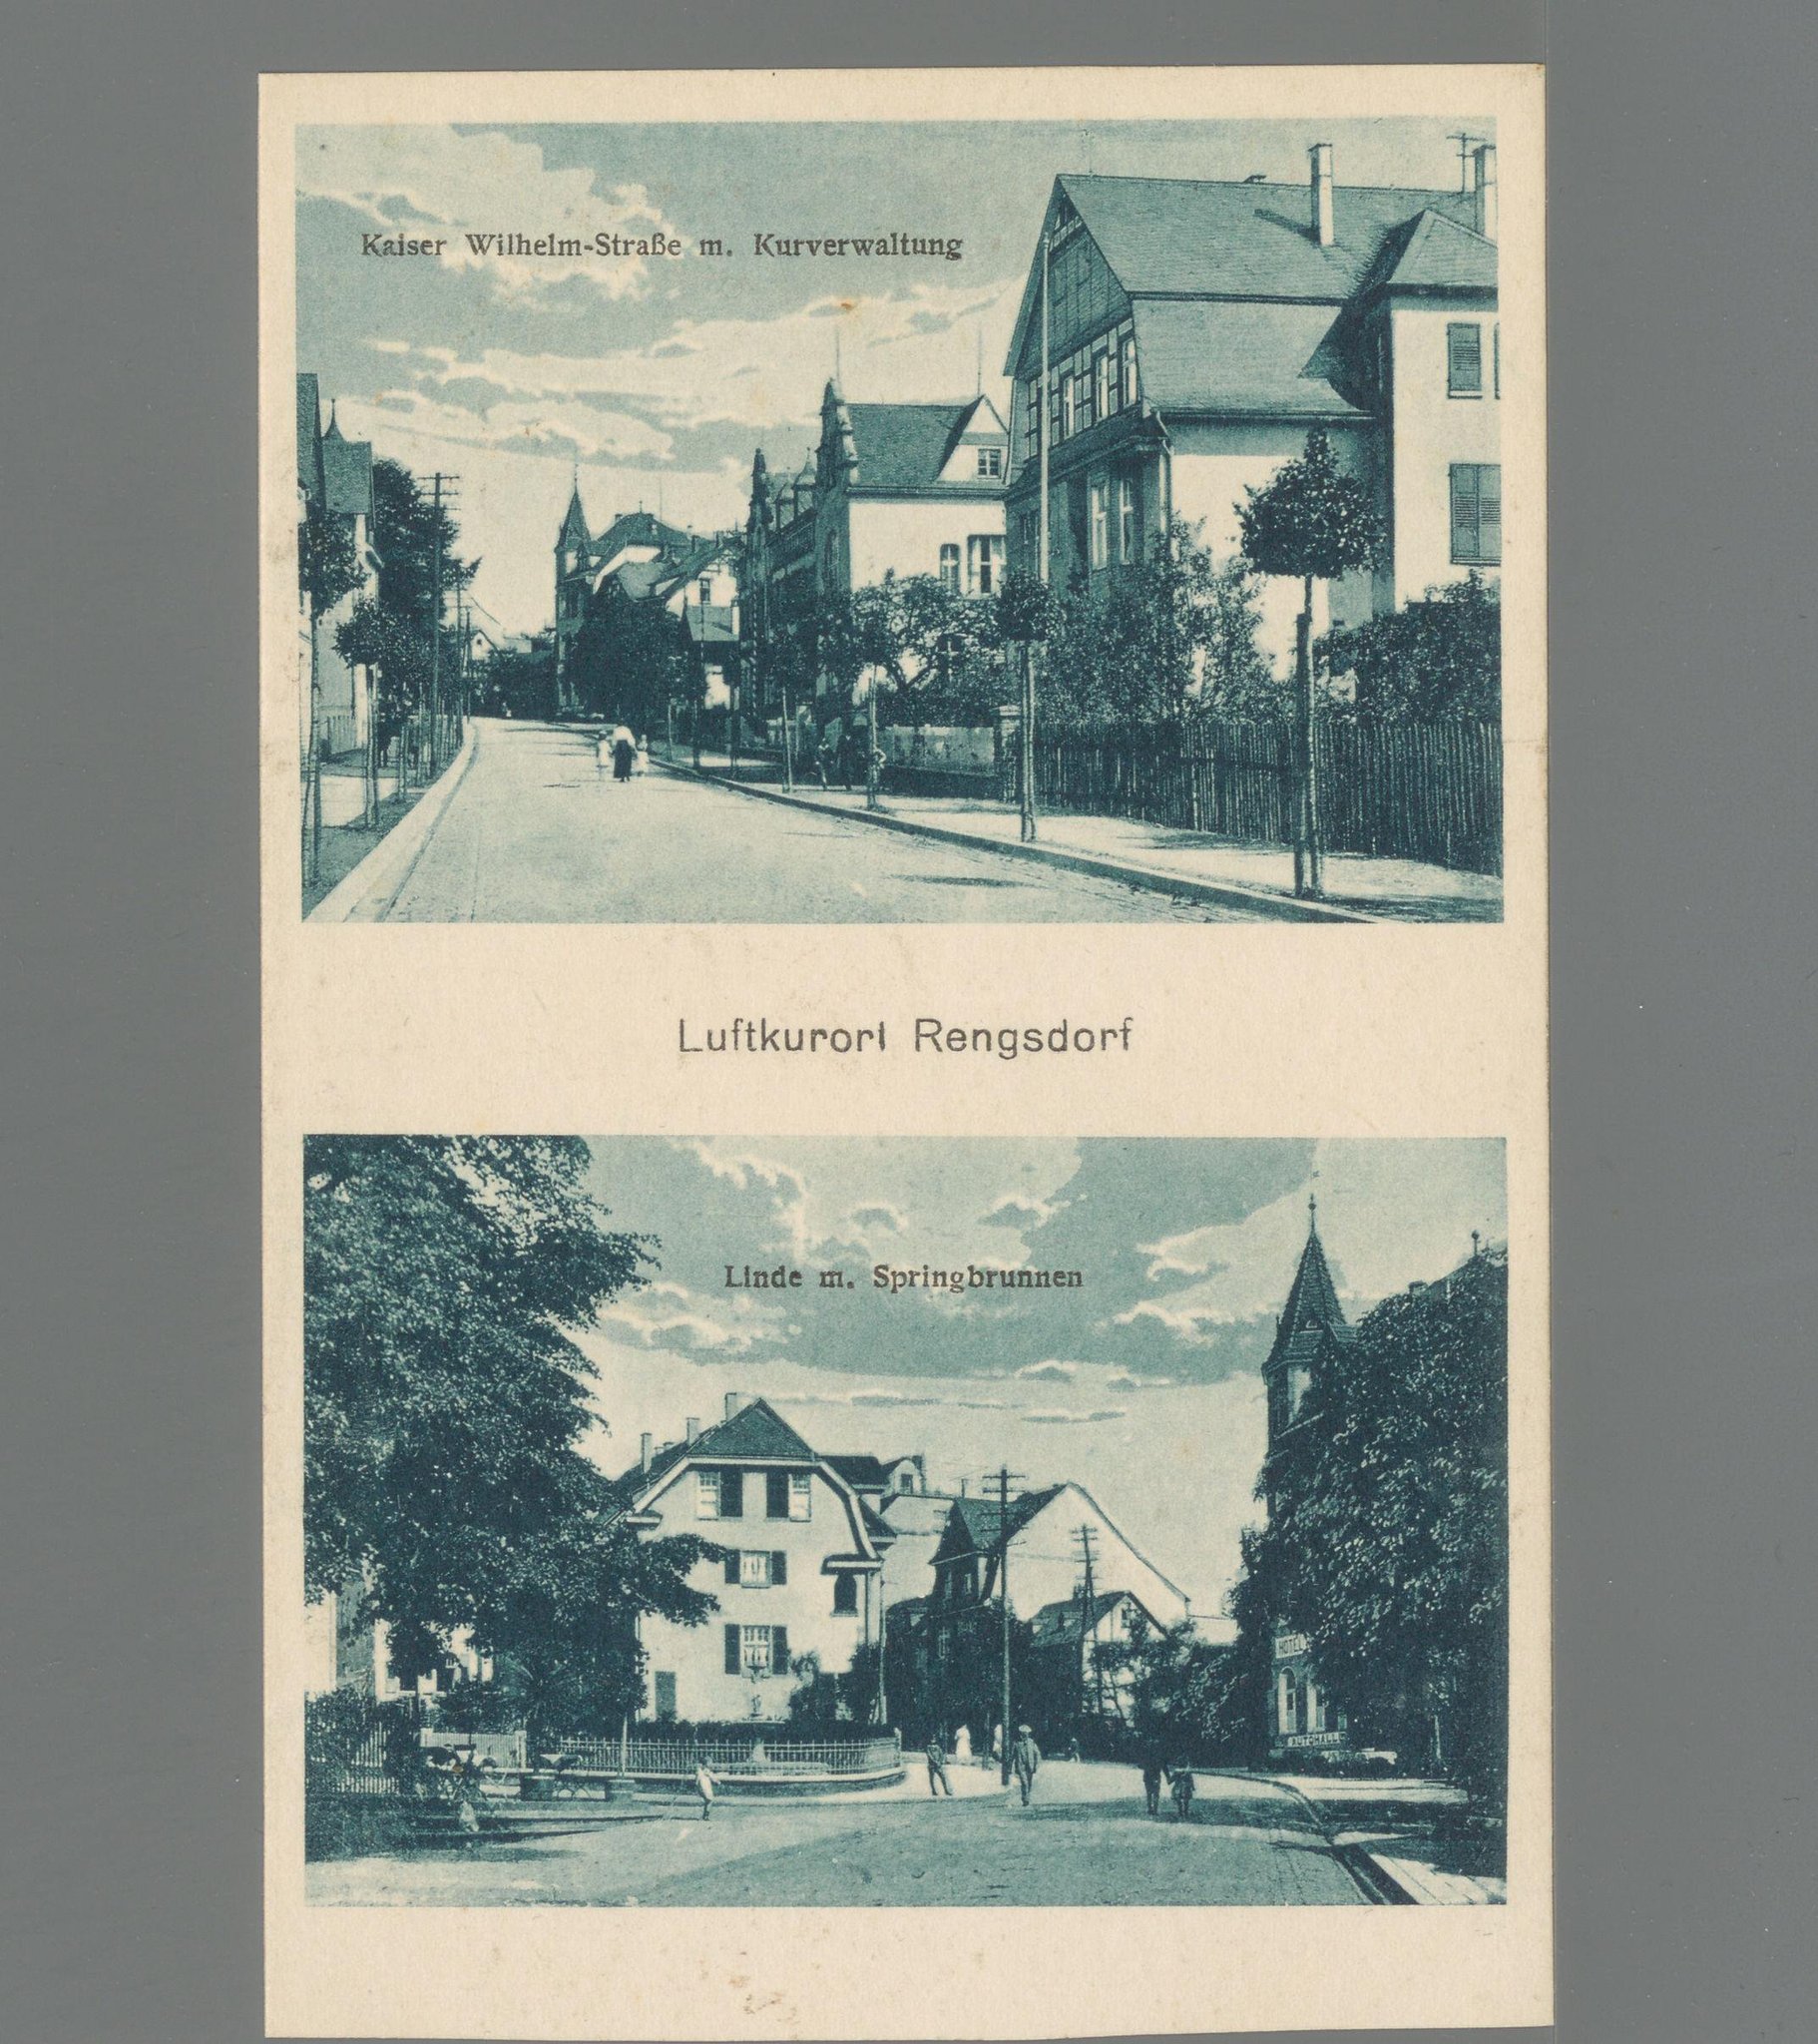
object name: ansichtkaart, prentbriefkaart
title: Luftkurort Rengsdorf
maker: Anonymous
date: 1905-1930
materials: cardboard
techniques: photograph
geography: rengsdorf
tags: watering-place, spa, ornamental fountain, street